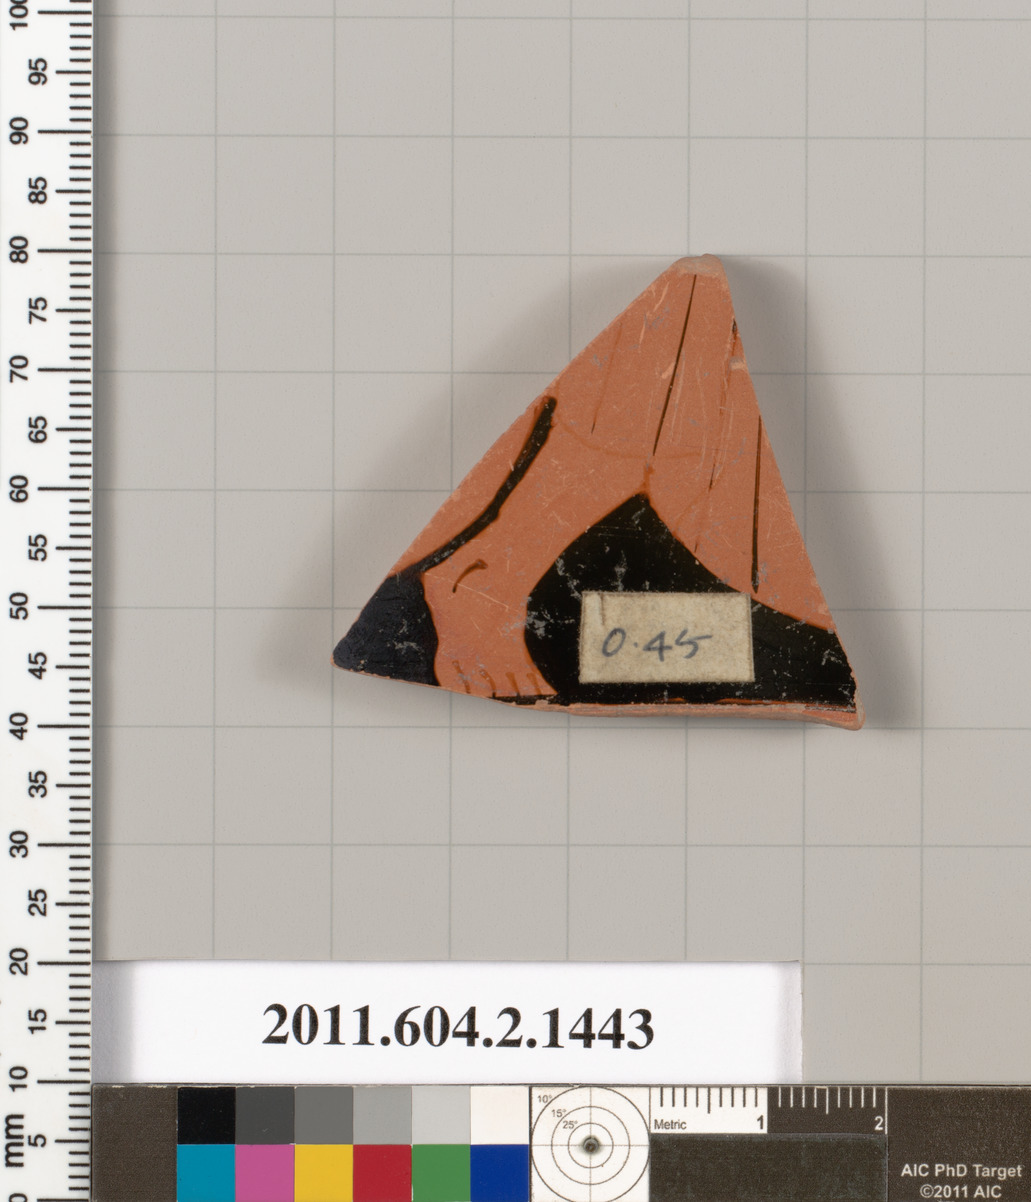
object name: skyphos fragment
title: Terracotta fragment of a skyphos (deep drinking cup)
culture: greek, attic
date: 425-401 BCE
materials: terracotta